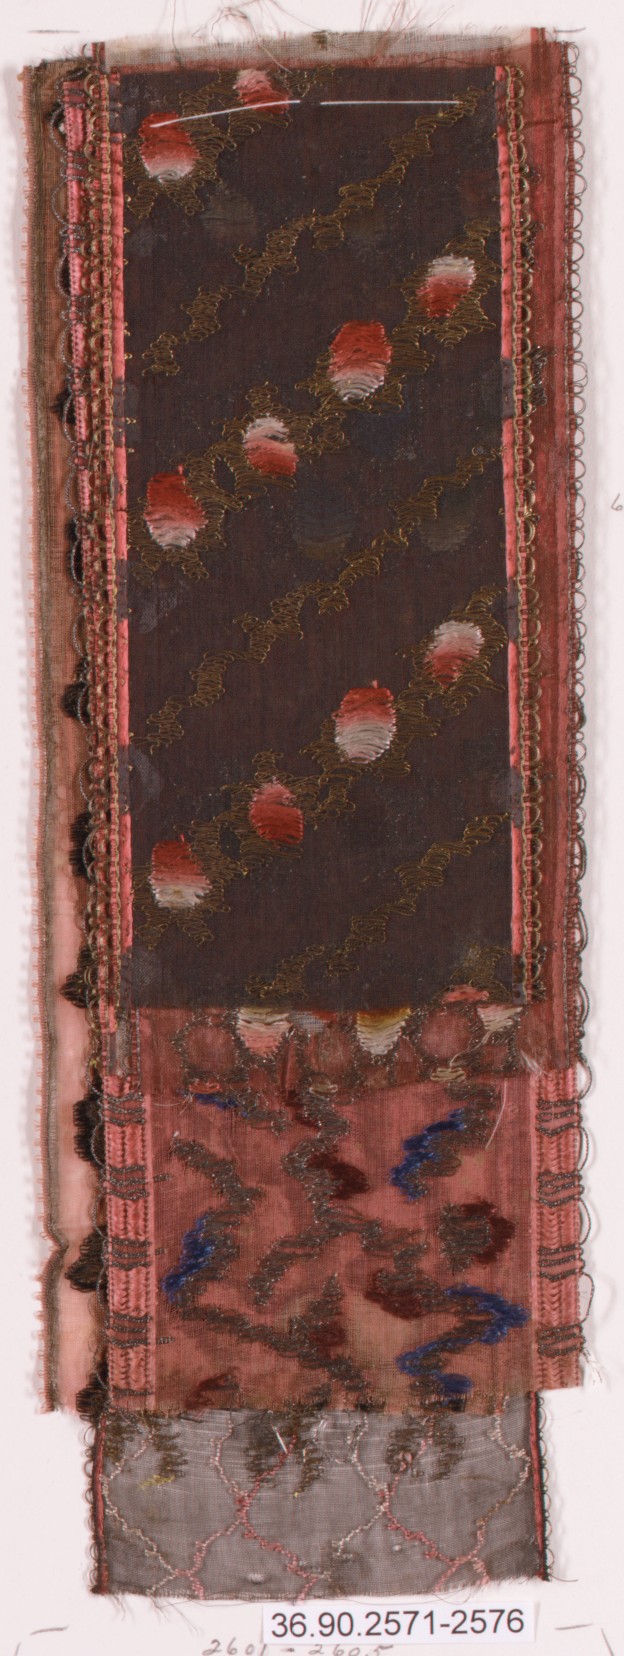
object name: ribbon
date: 1801-1900